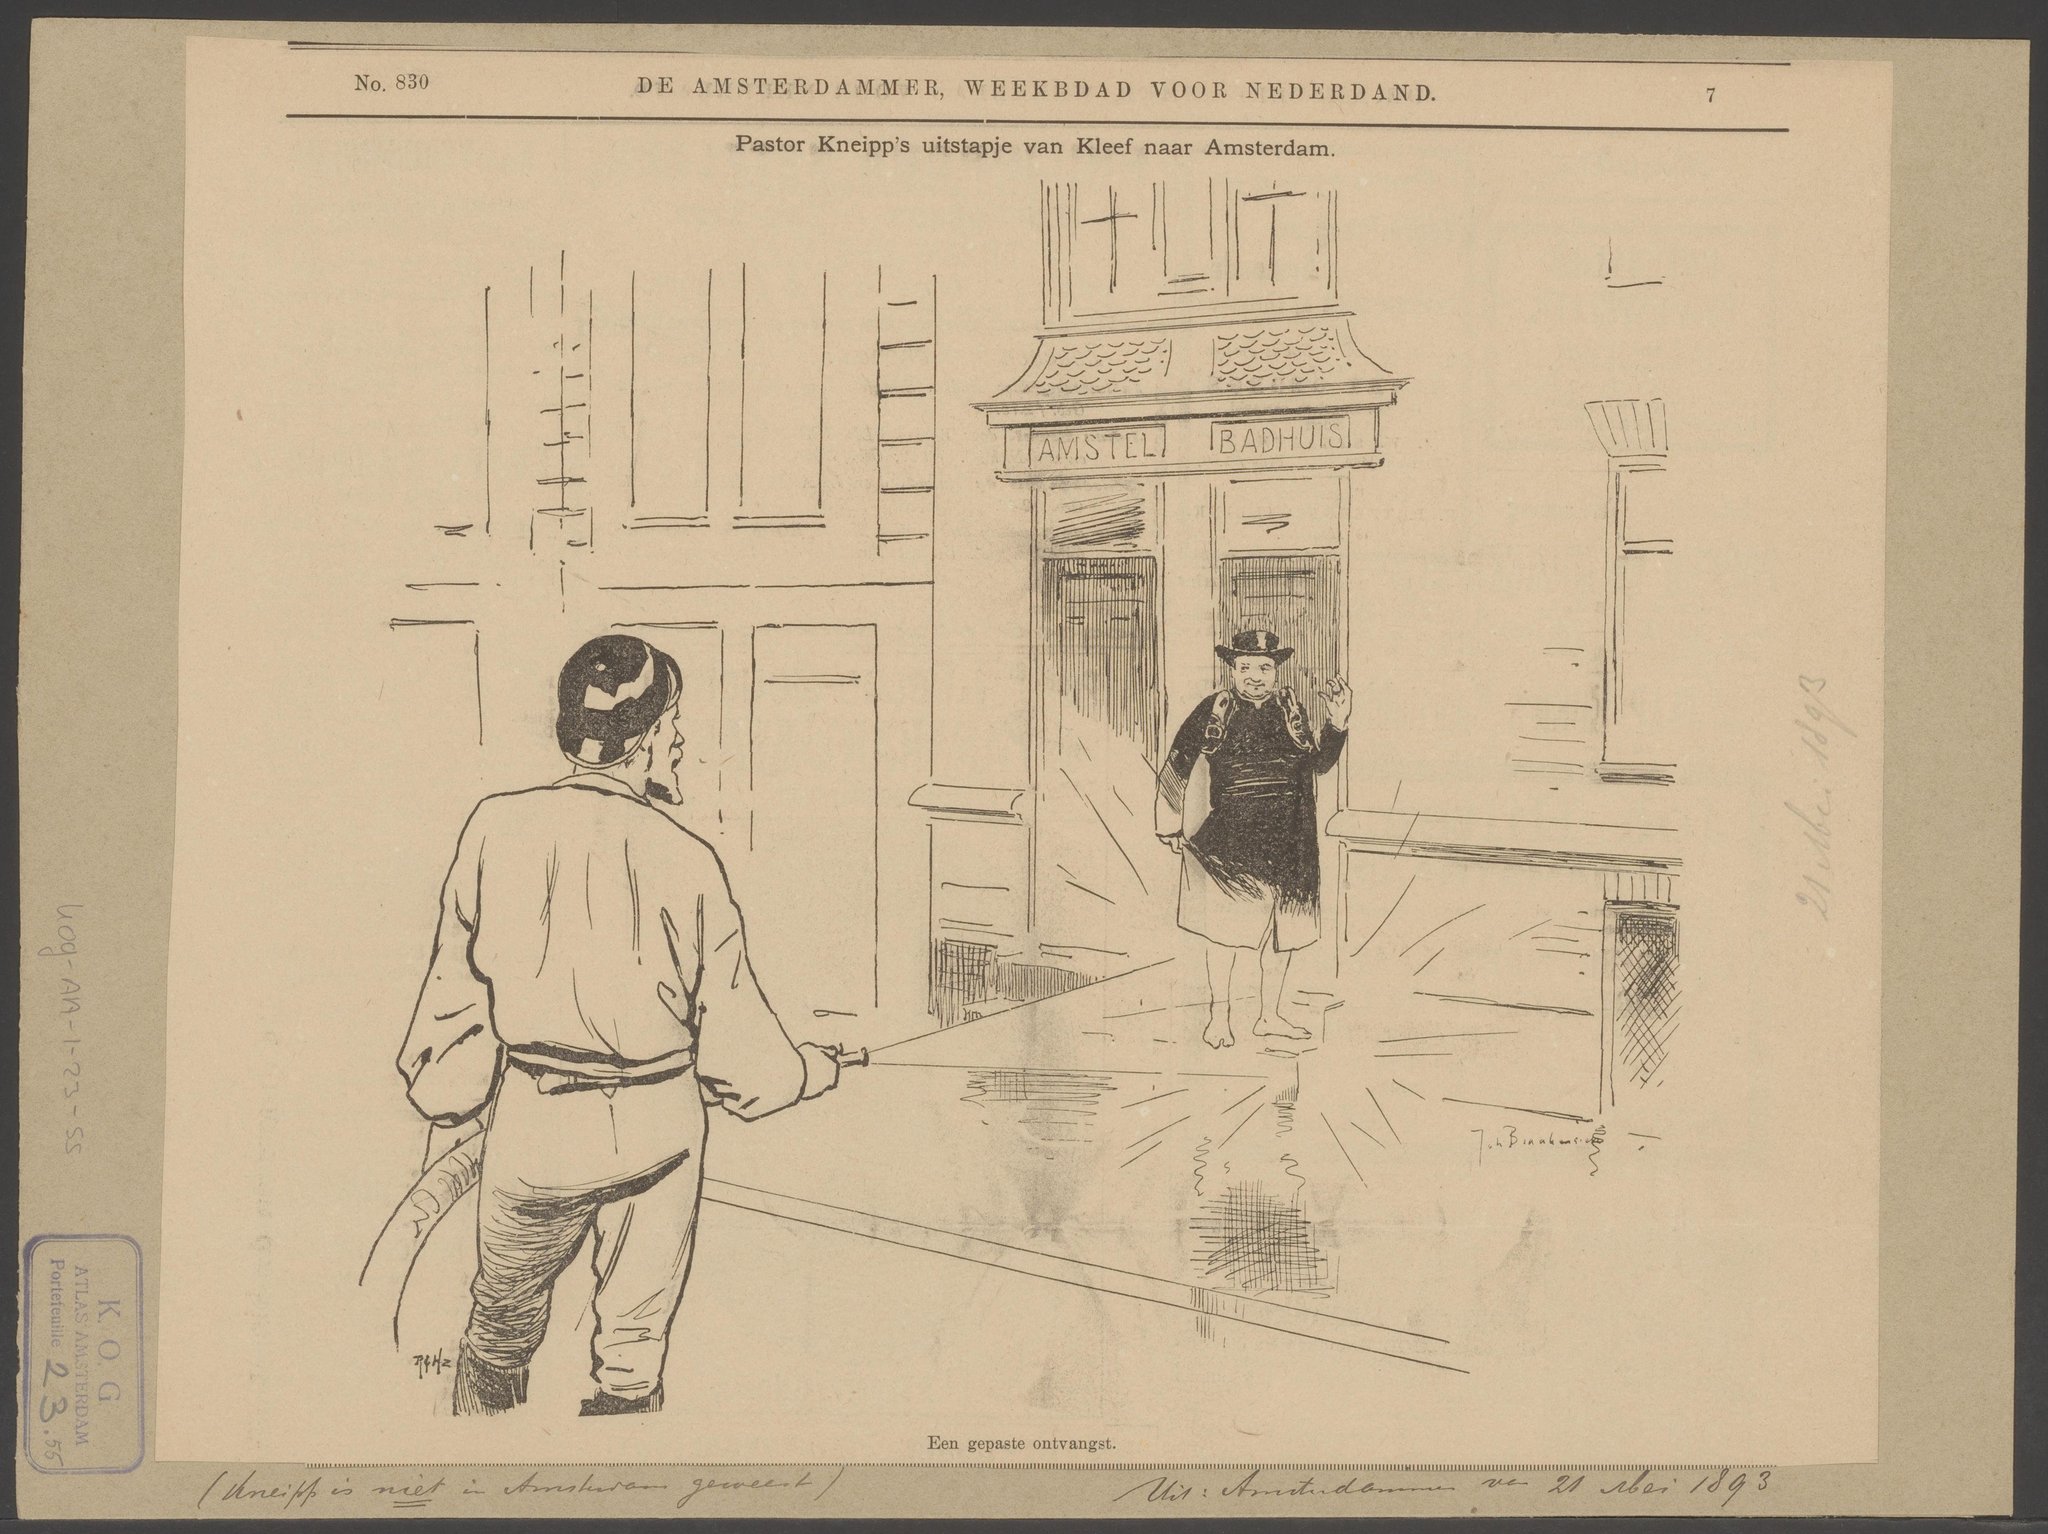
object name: photomechanical print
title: Pastor Kneipp's uitstapje van Kleef naar Amsterdam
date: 1893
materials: paper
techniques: letterpress printing, line block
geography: amsterdam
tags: public baths, fire-hose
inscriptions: signature: ‘R&Hz.’, collector's mark: Lugt 1641b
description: Prent uit: De Amsterdammer 17 (1893), nr. 830, 21 mei 1893, p. 7.